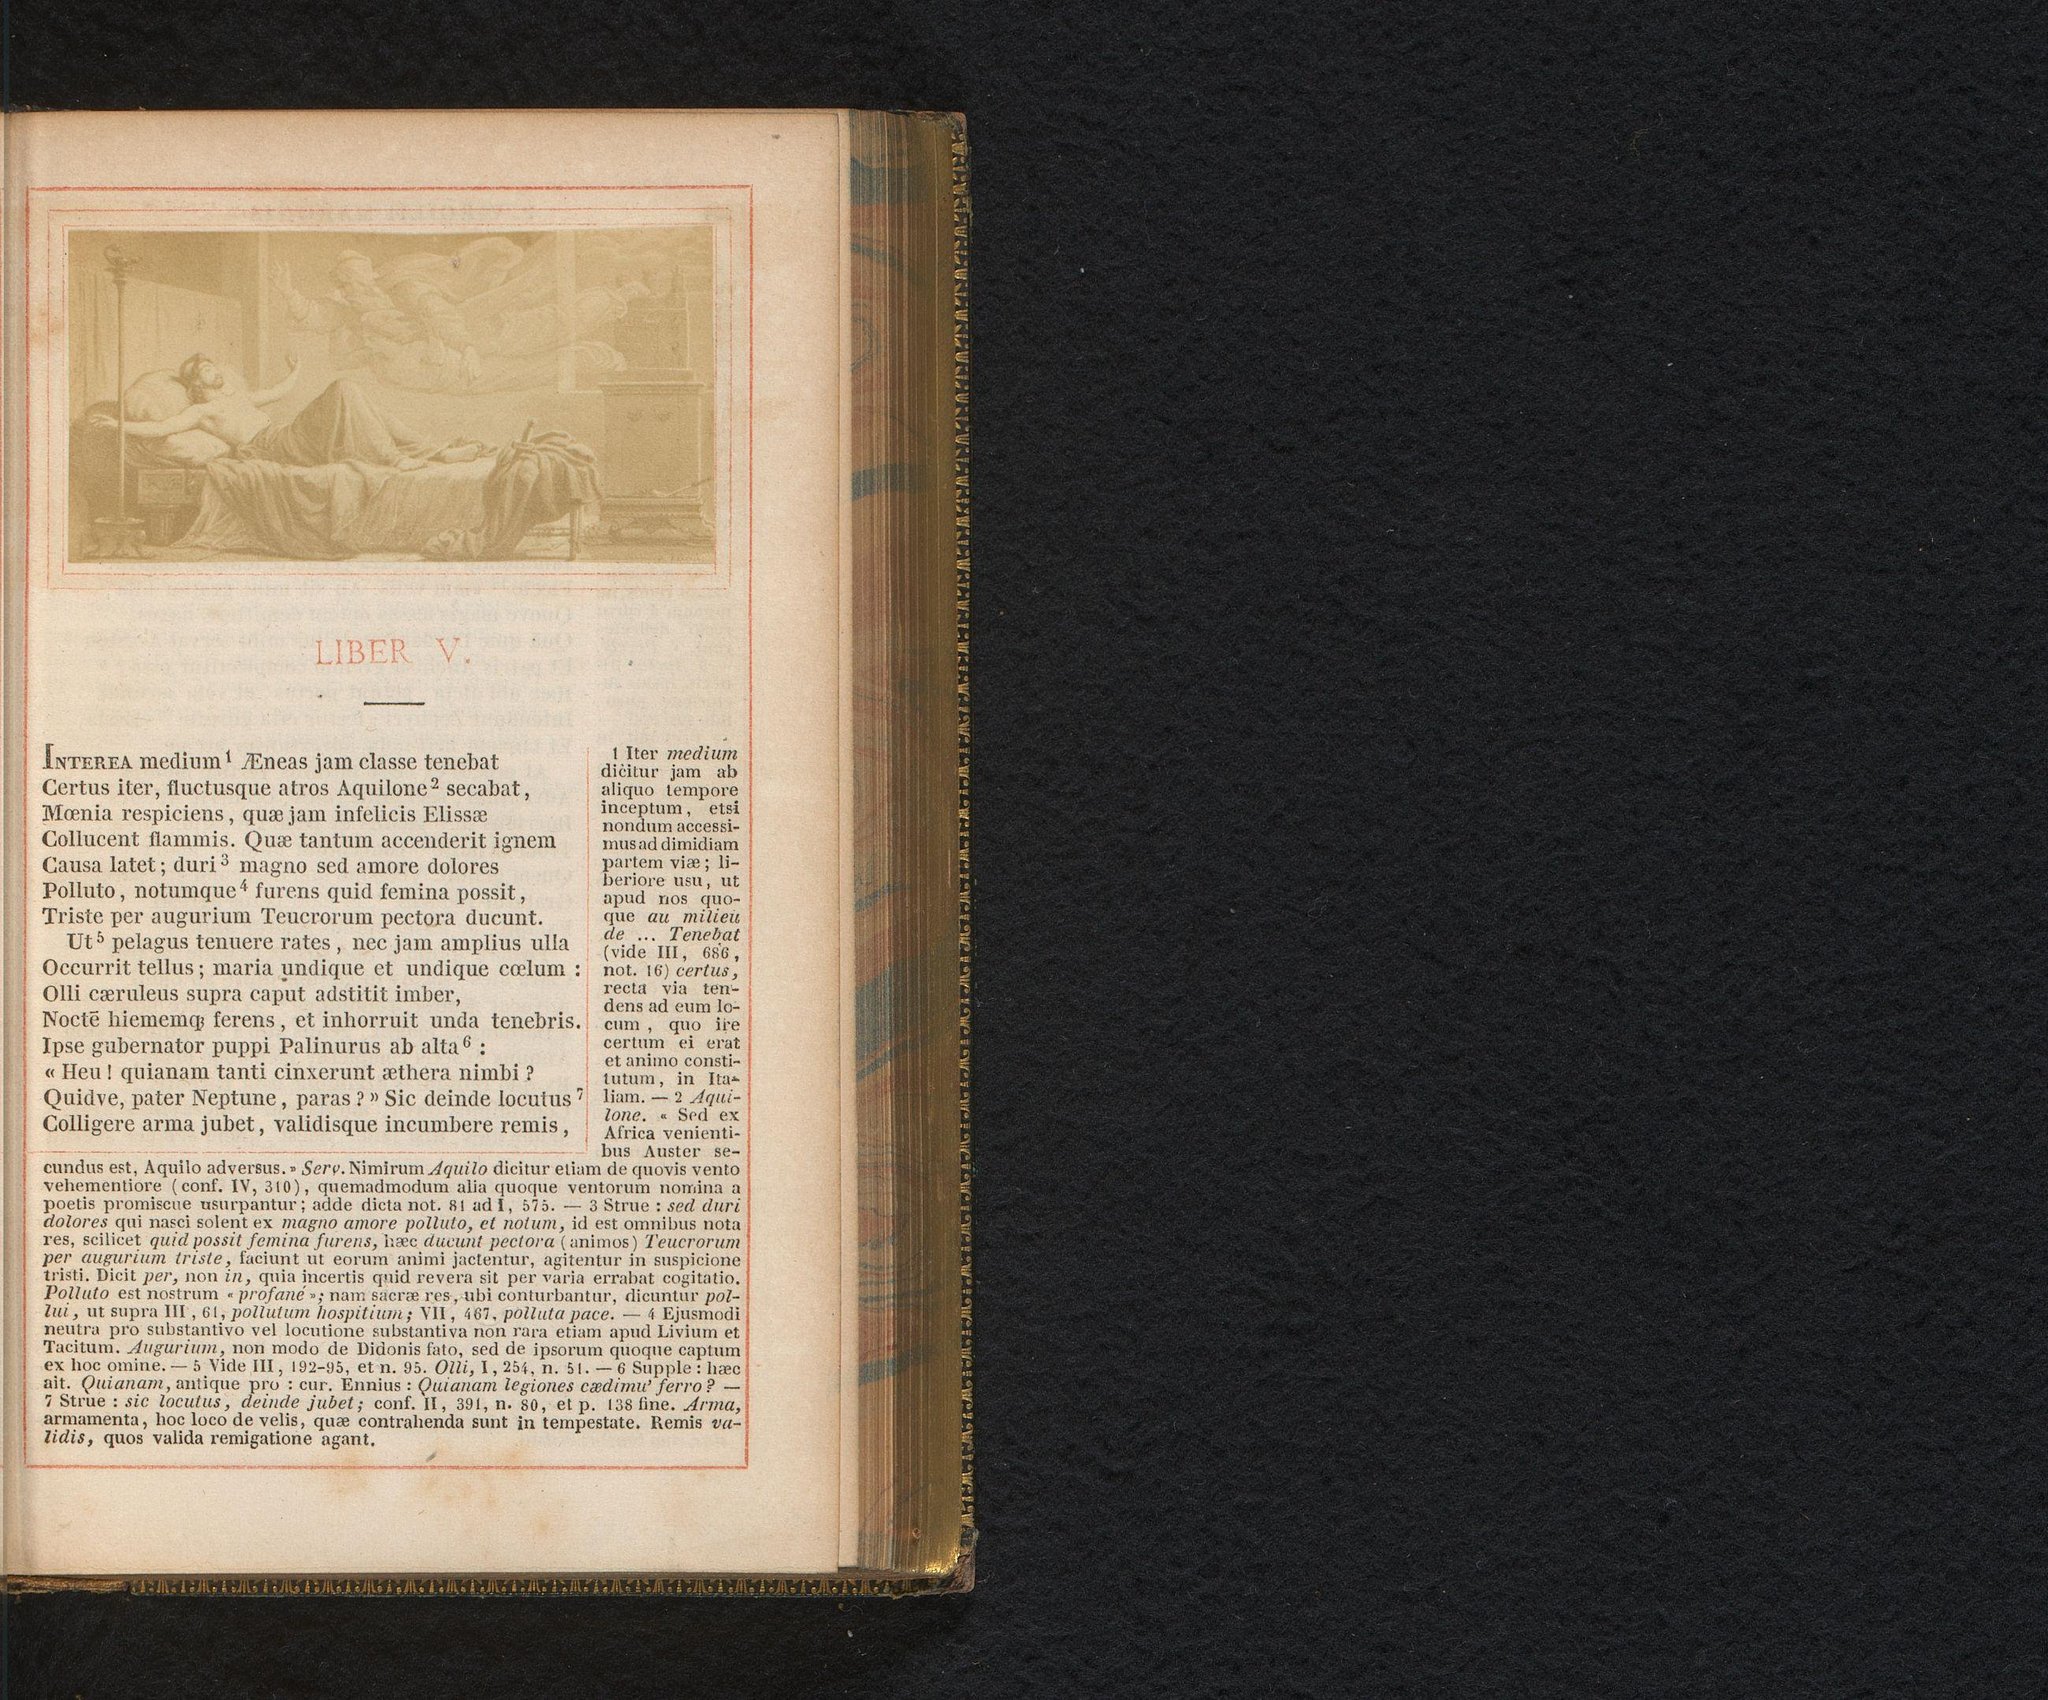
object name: reproduction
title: Fotoreproductie van een schilderij, voorstellende Aeneas wordt bezocht door de schim van Anchises, scène uit Virgilius' Aeneis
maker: Anonymous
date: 1853-1858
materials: paper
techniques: albumen print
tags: anchises' spirit appears to aeneas in his sleep